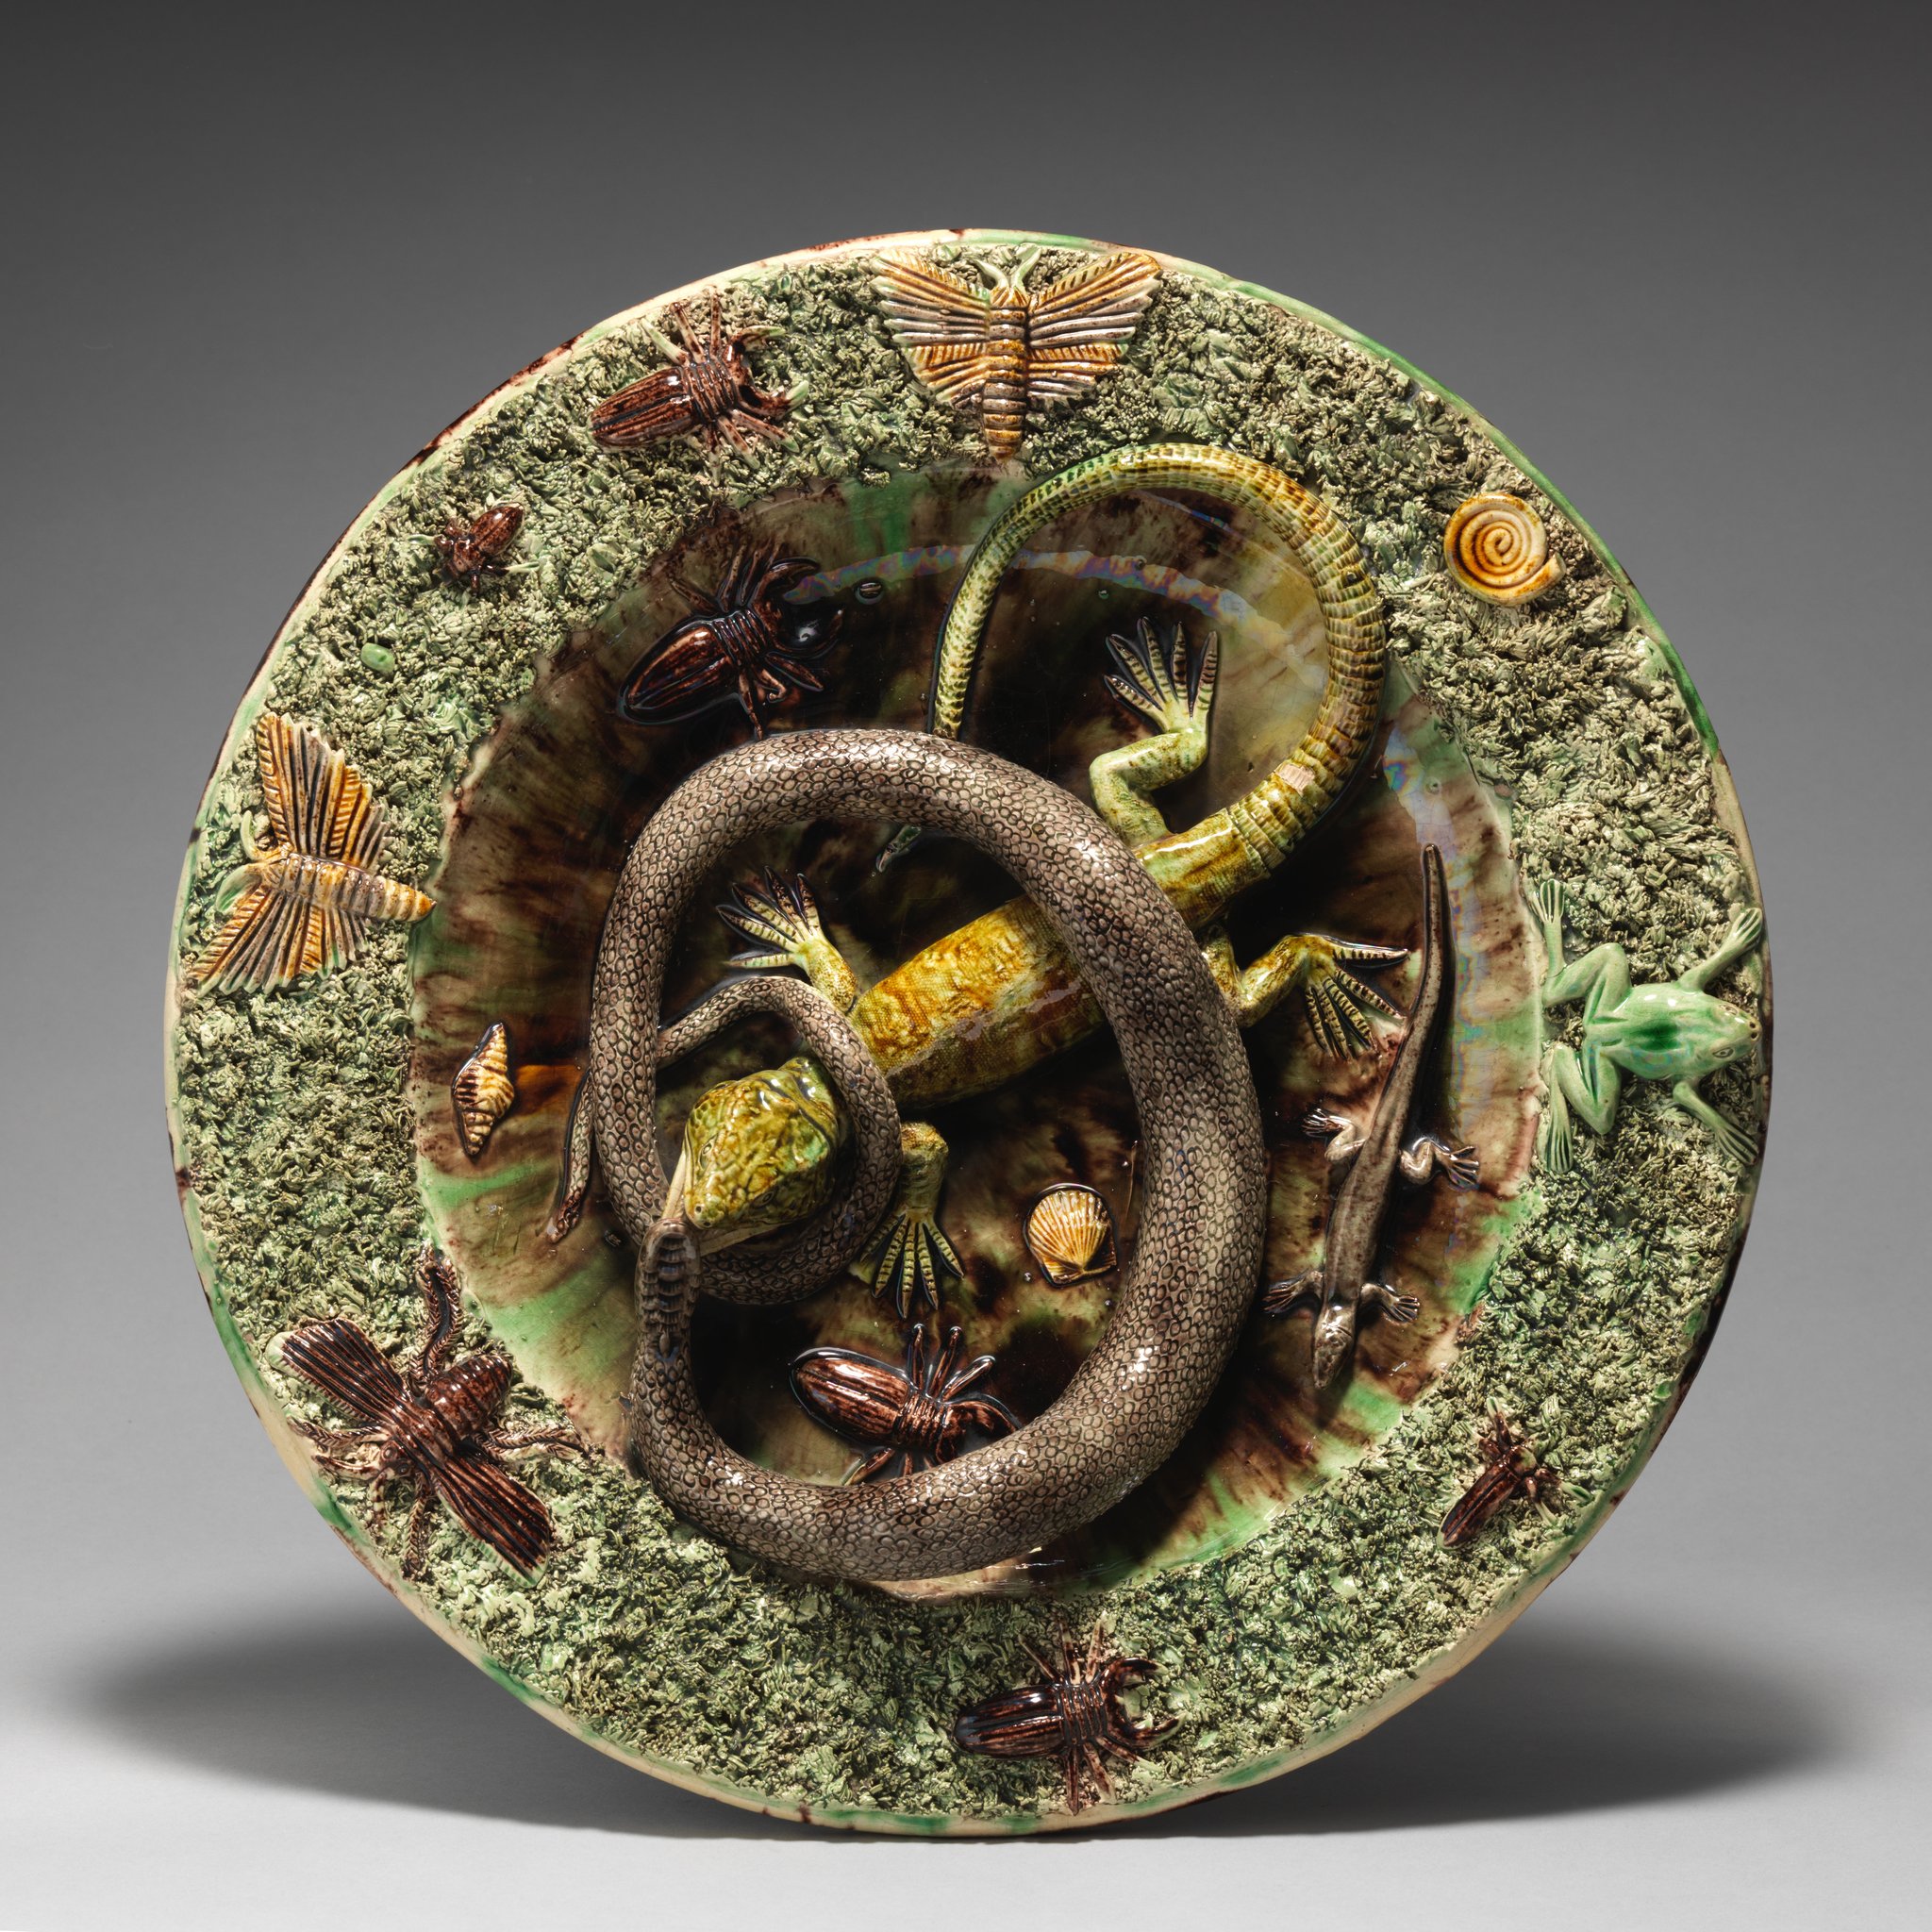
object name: dish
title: Round dish with fighting lizard and snake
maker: manuel mafra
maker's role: maker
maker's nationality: portuguese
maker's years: 1830-1905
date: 1865-1887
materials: earthenware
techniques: glazing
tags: insects,lizards,snakes